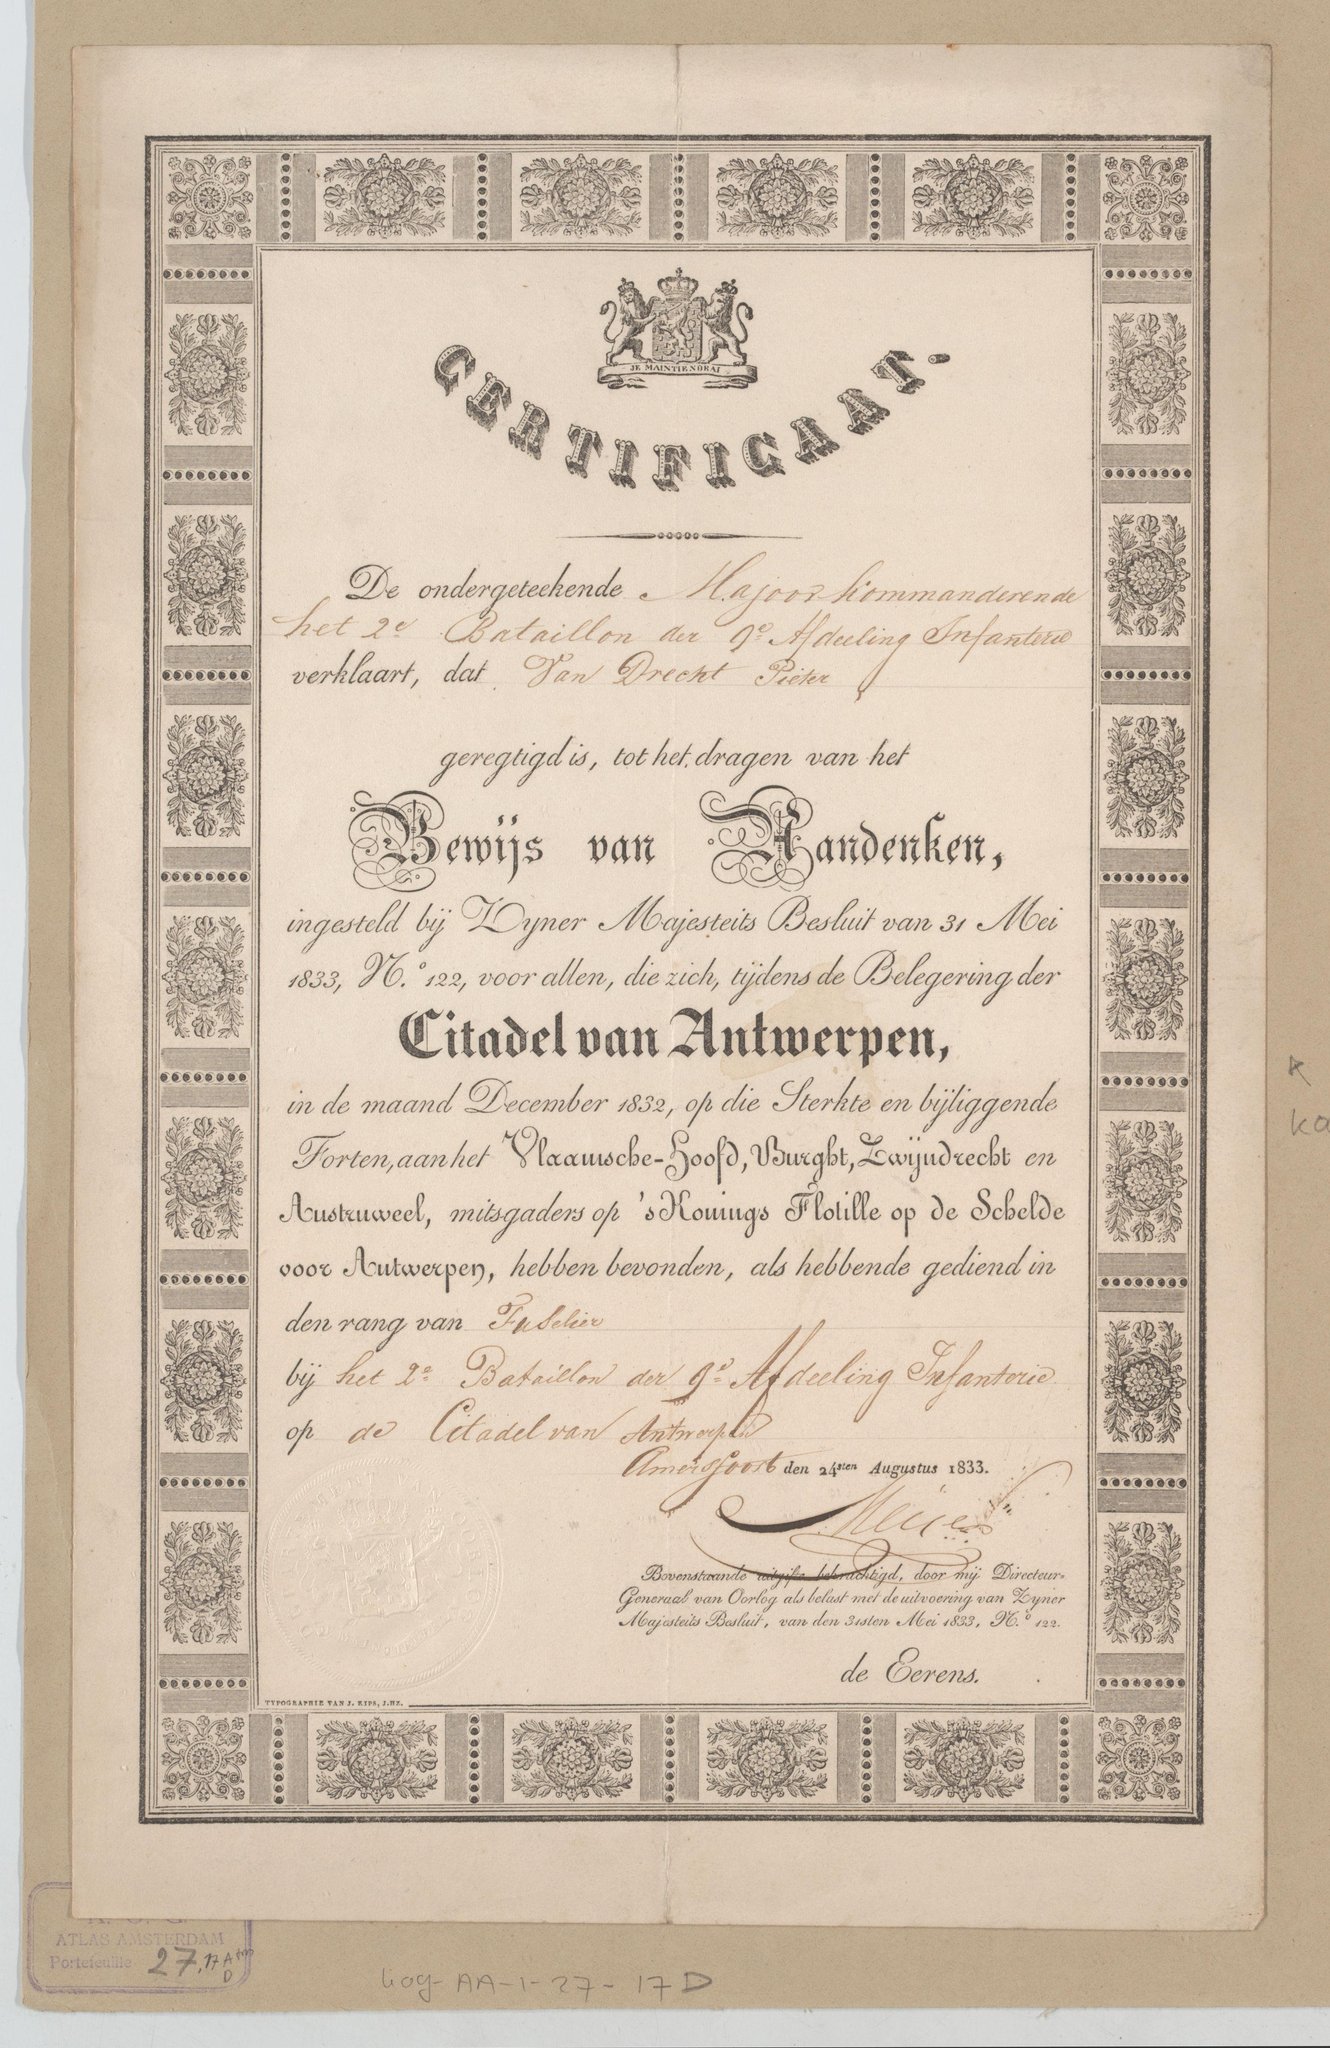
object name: text sheet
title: Certificaat van Pieter van Drecht voor zijn deelname aan het Beleg van Antwerpen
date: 1833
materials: paper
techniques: letterpress printing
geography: netherlands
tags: military honours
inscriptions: collector's mark: Lugt 1641b, coat of arms: ‘Departement van Oorlog’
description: Onderwerpsrubriek binnen de Atlas Amsterdam: Landmacht: Gebouwen / Herinneringen aan officieren, stadssoldaten / Nationale militie / (diverse korpsen) / Padvinders / Parade.